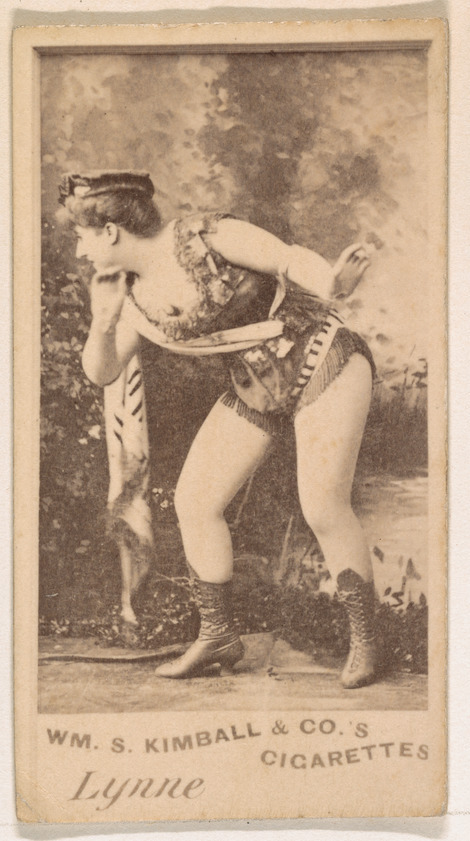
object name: photograph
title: Miss Lynne, from the Actresses series (N203) issued by Wm. S. Kimball & Co.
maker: william s. kimball & company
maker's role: publisher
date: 1889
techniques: color lithograph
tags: portraits,women,actresses